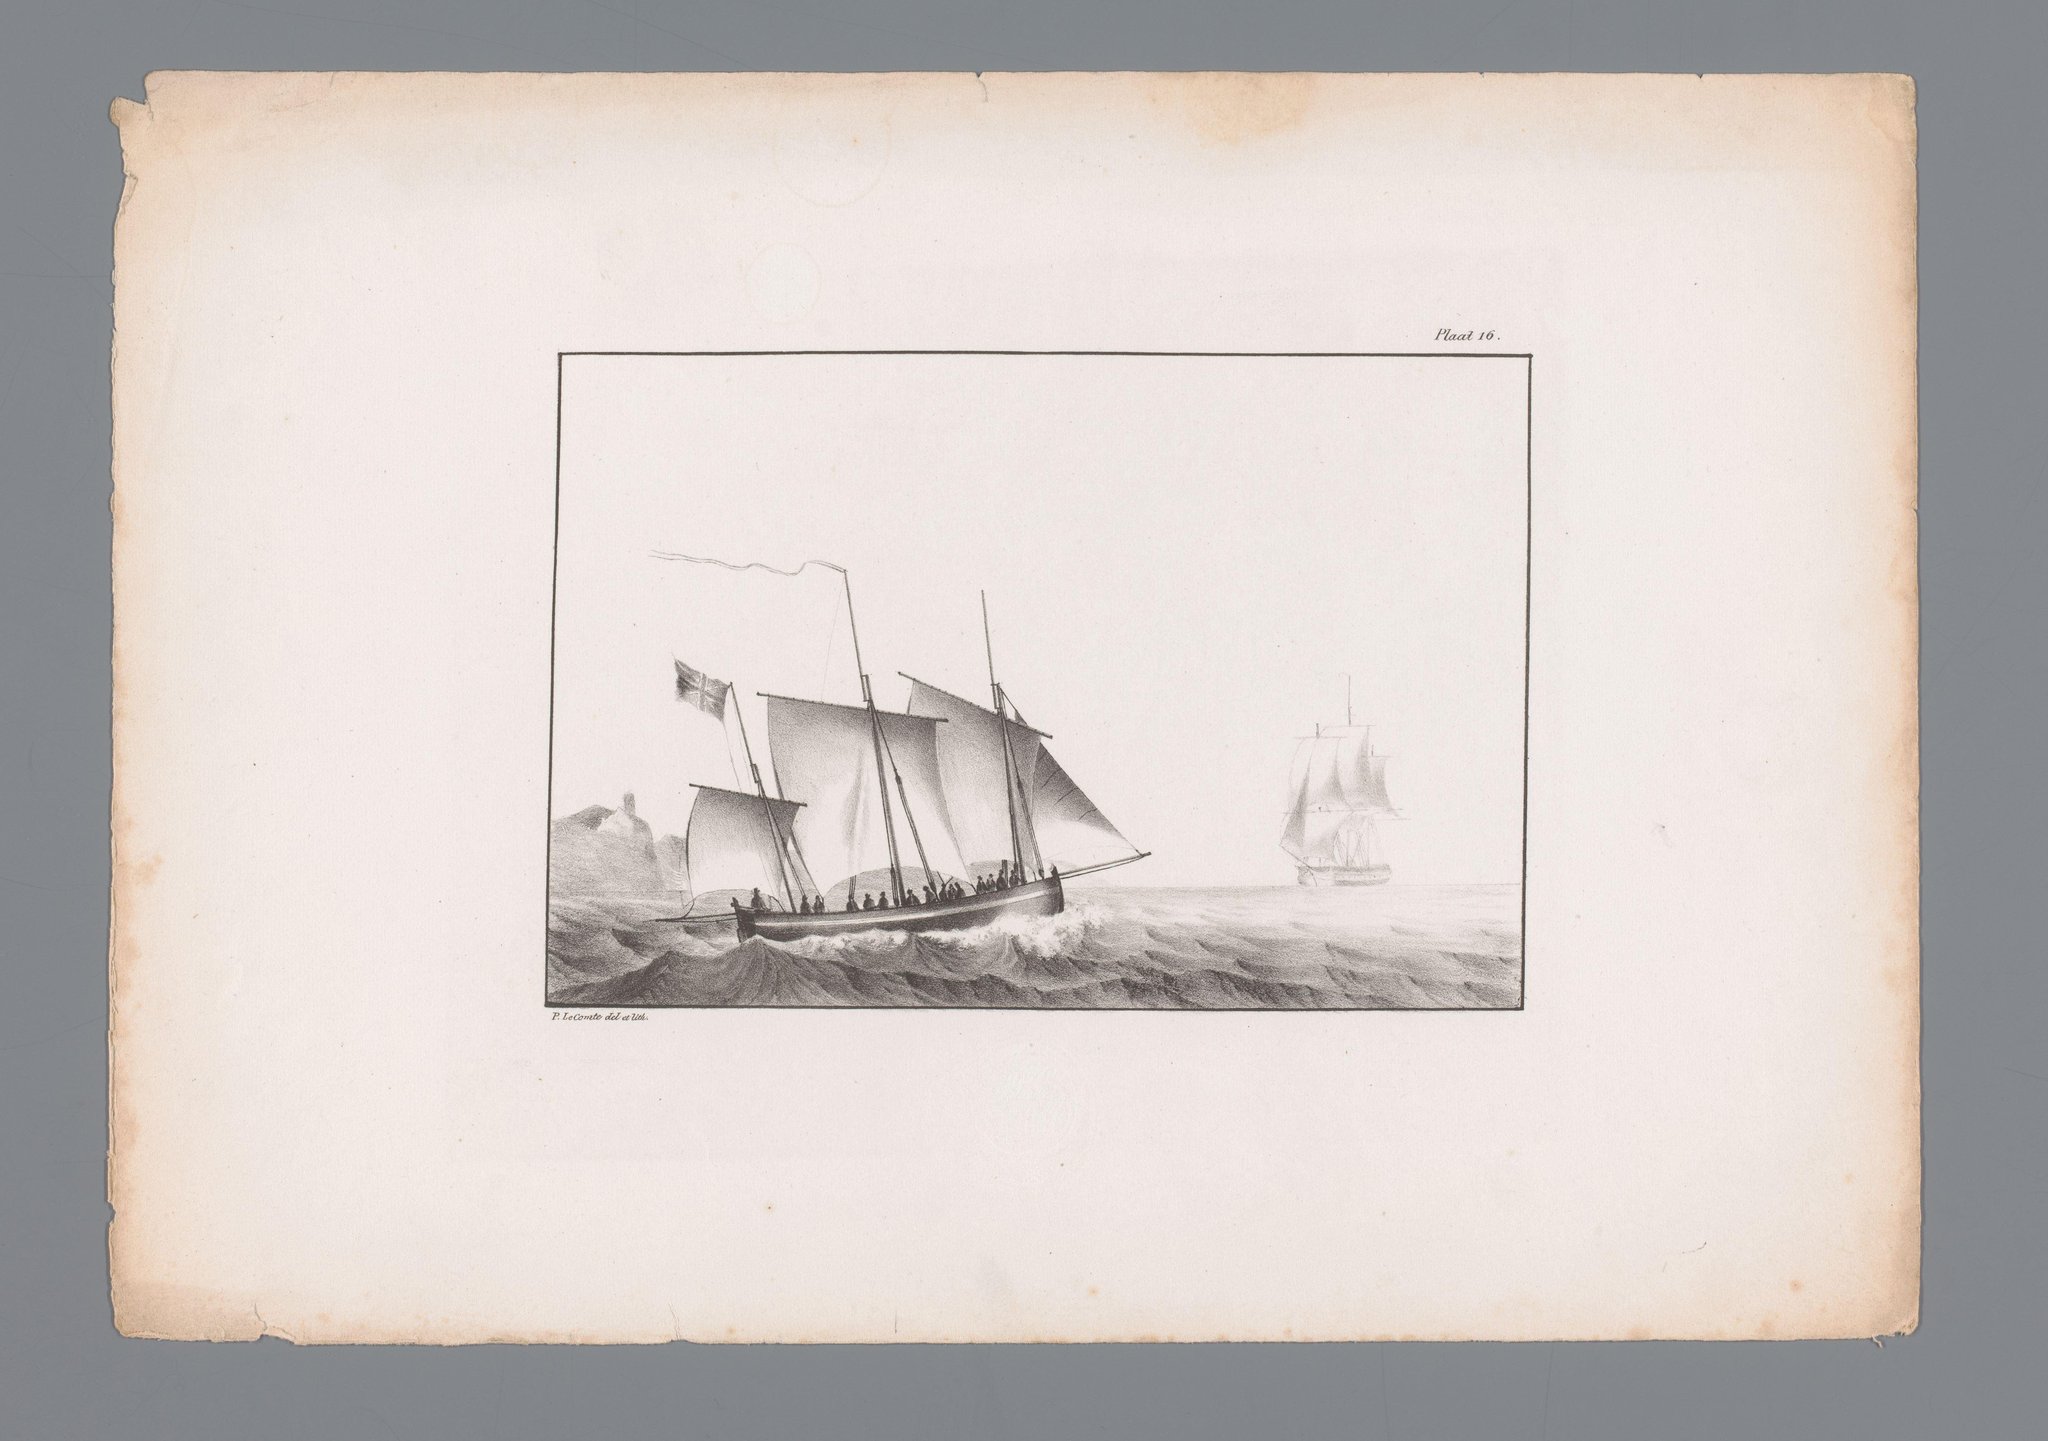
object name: print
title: Afbeeldingen van schepen en vaartuigen, in verschillende bewegingen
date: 1831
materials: paper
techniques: lithograph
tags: sailing-ship, sailing-boat, ships (in general)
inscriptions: collector's mark: ‘PLC RMWO’, collector's mark: Lugt 2228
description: Genummerd rechtsboven: Plaat 16. Deze prent maakt deel uit van een omslag met negentien prenten.